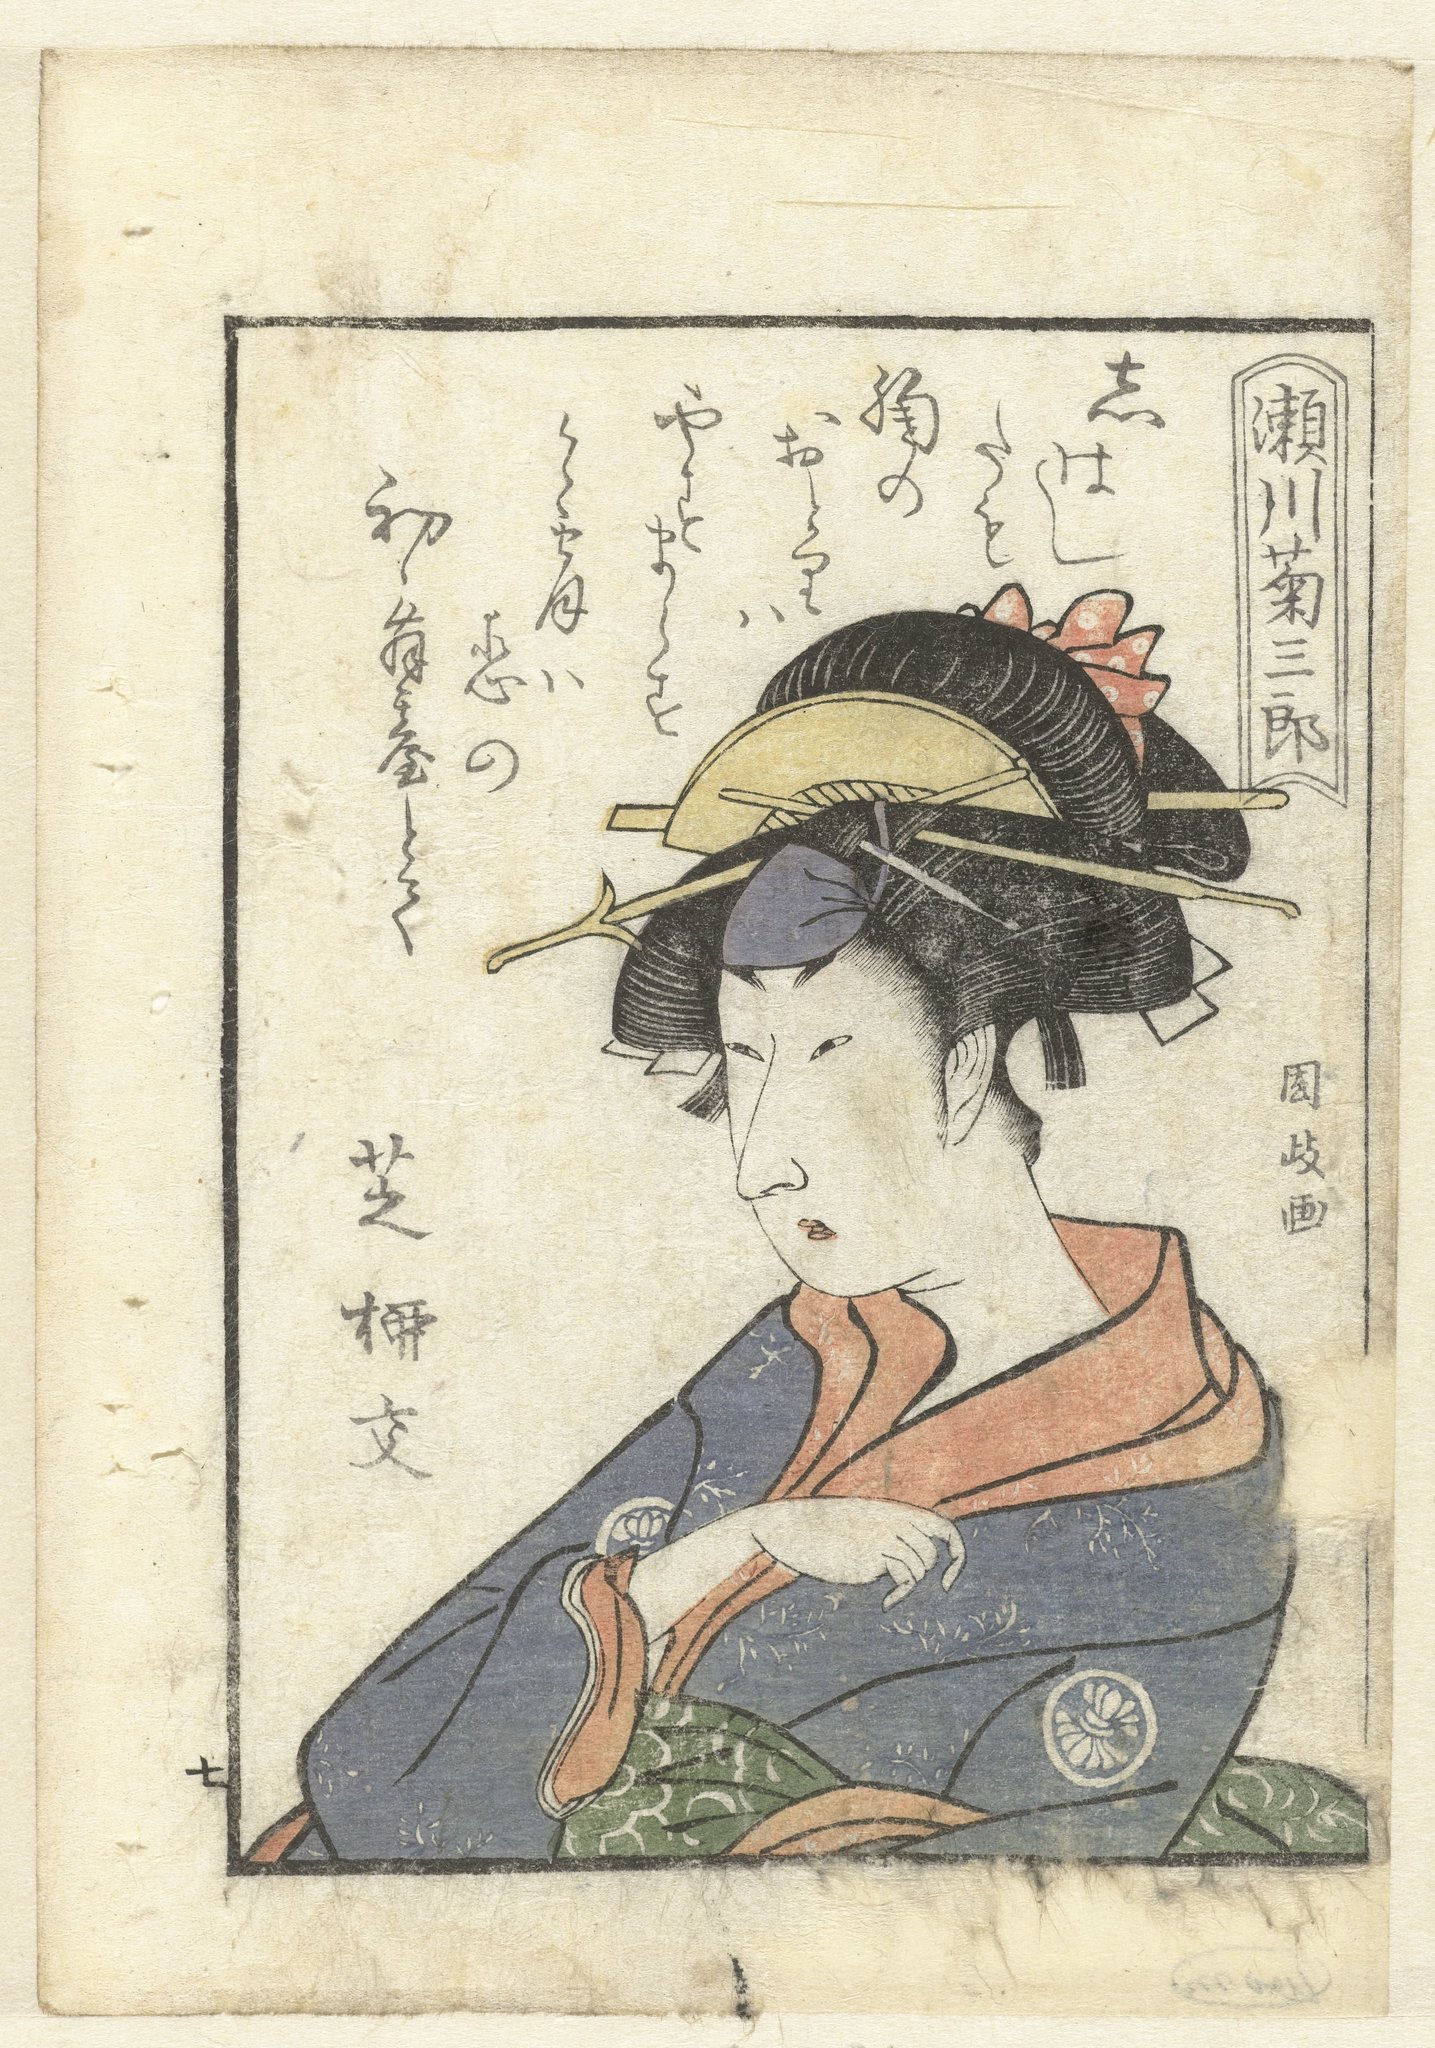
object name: print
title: Een kijkje achter de schermen bij de toneelspelers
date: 1799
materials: paper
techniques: woodcut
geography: edo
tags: portrait of actor, actress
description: Busteportret van de acteur Segawa Kikusaburo, in vrouwenrol, in paars en rode kimono, afgebeeld onder een aan hem gericht liefdesgedicht; in de linker marge het paginanummer zeven. Blad uit het Japanse boek Yakusha gakuya tsu.